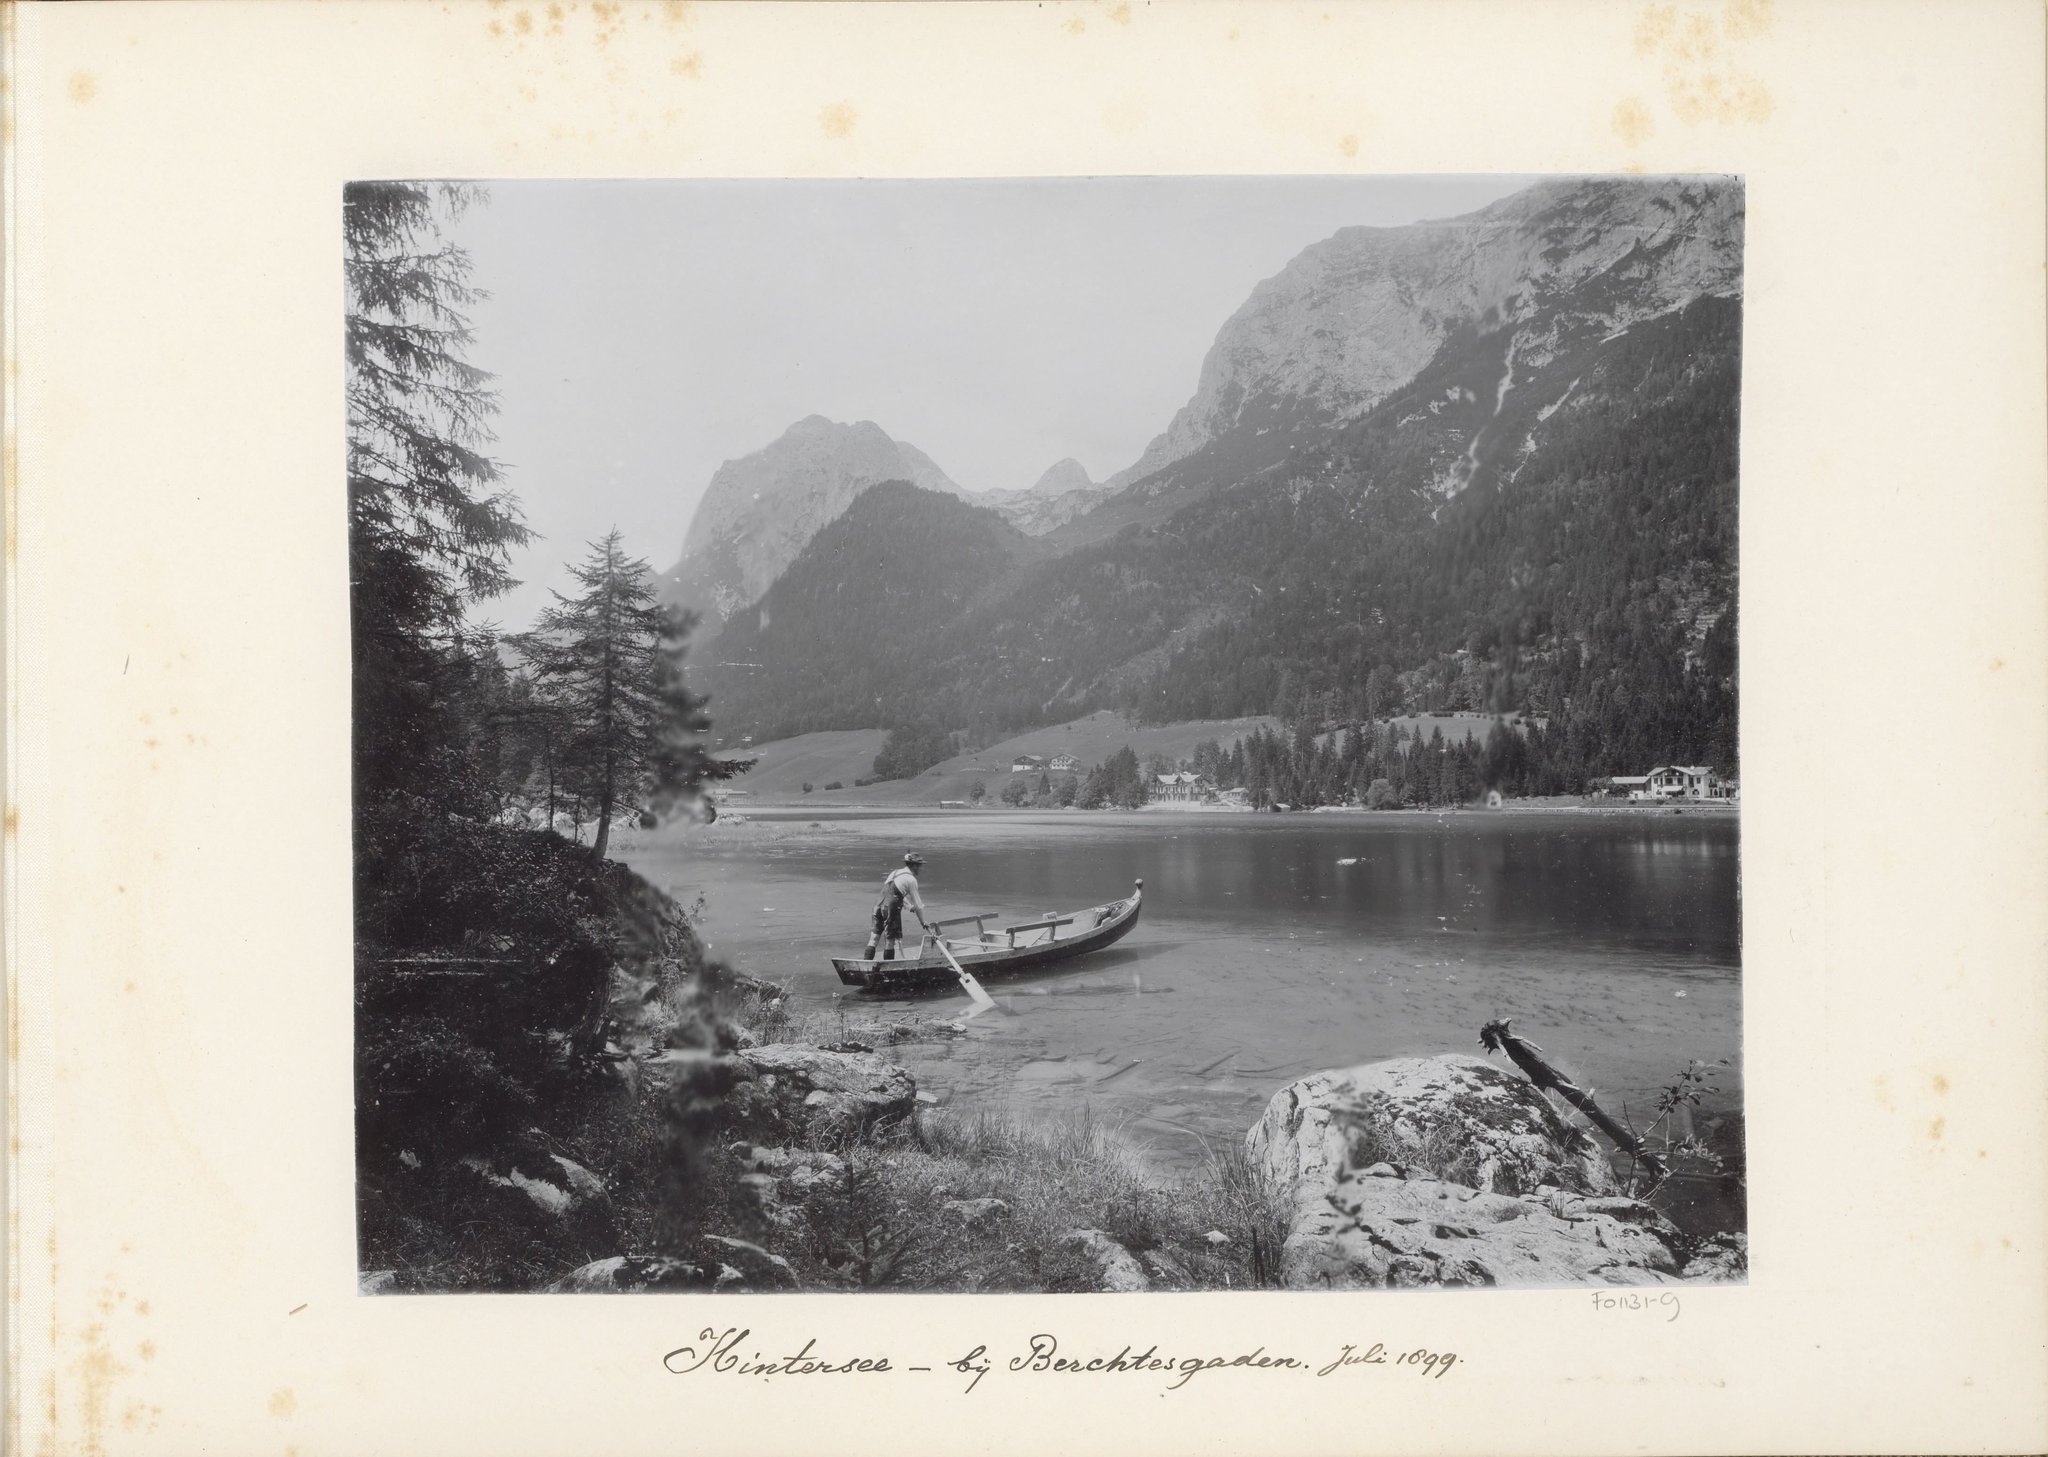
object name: photograph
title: Man in een roeiboot op de Hintersee bij Berchtesgaden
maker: Anonymous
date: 1880-1899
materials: paper, photographic support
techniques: collodion silver print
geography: bavaria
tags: rowing-boat, canoe, etc., lake, mountain-range, snow peaks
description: Onderdeel van Reisalbum met bezienswaardigheden in Duitsland, Oostenrijk, Zwitserland, Luxemburg en België.